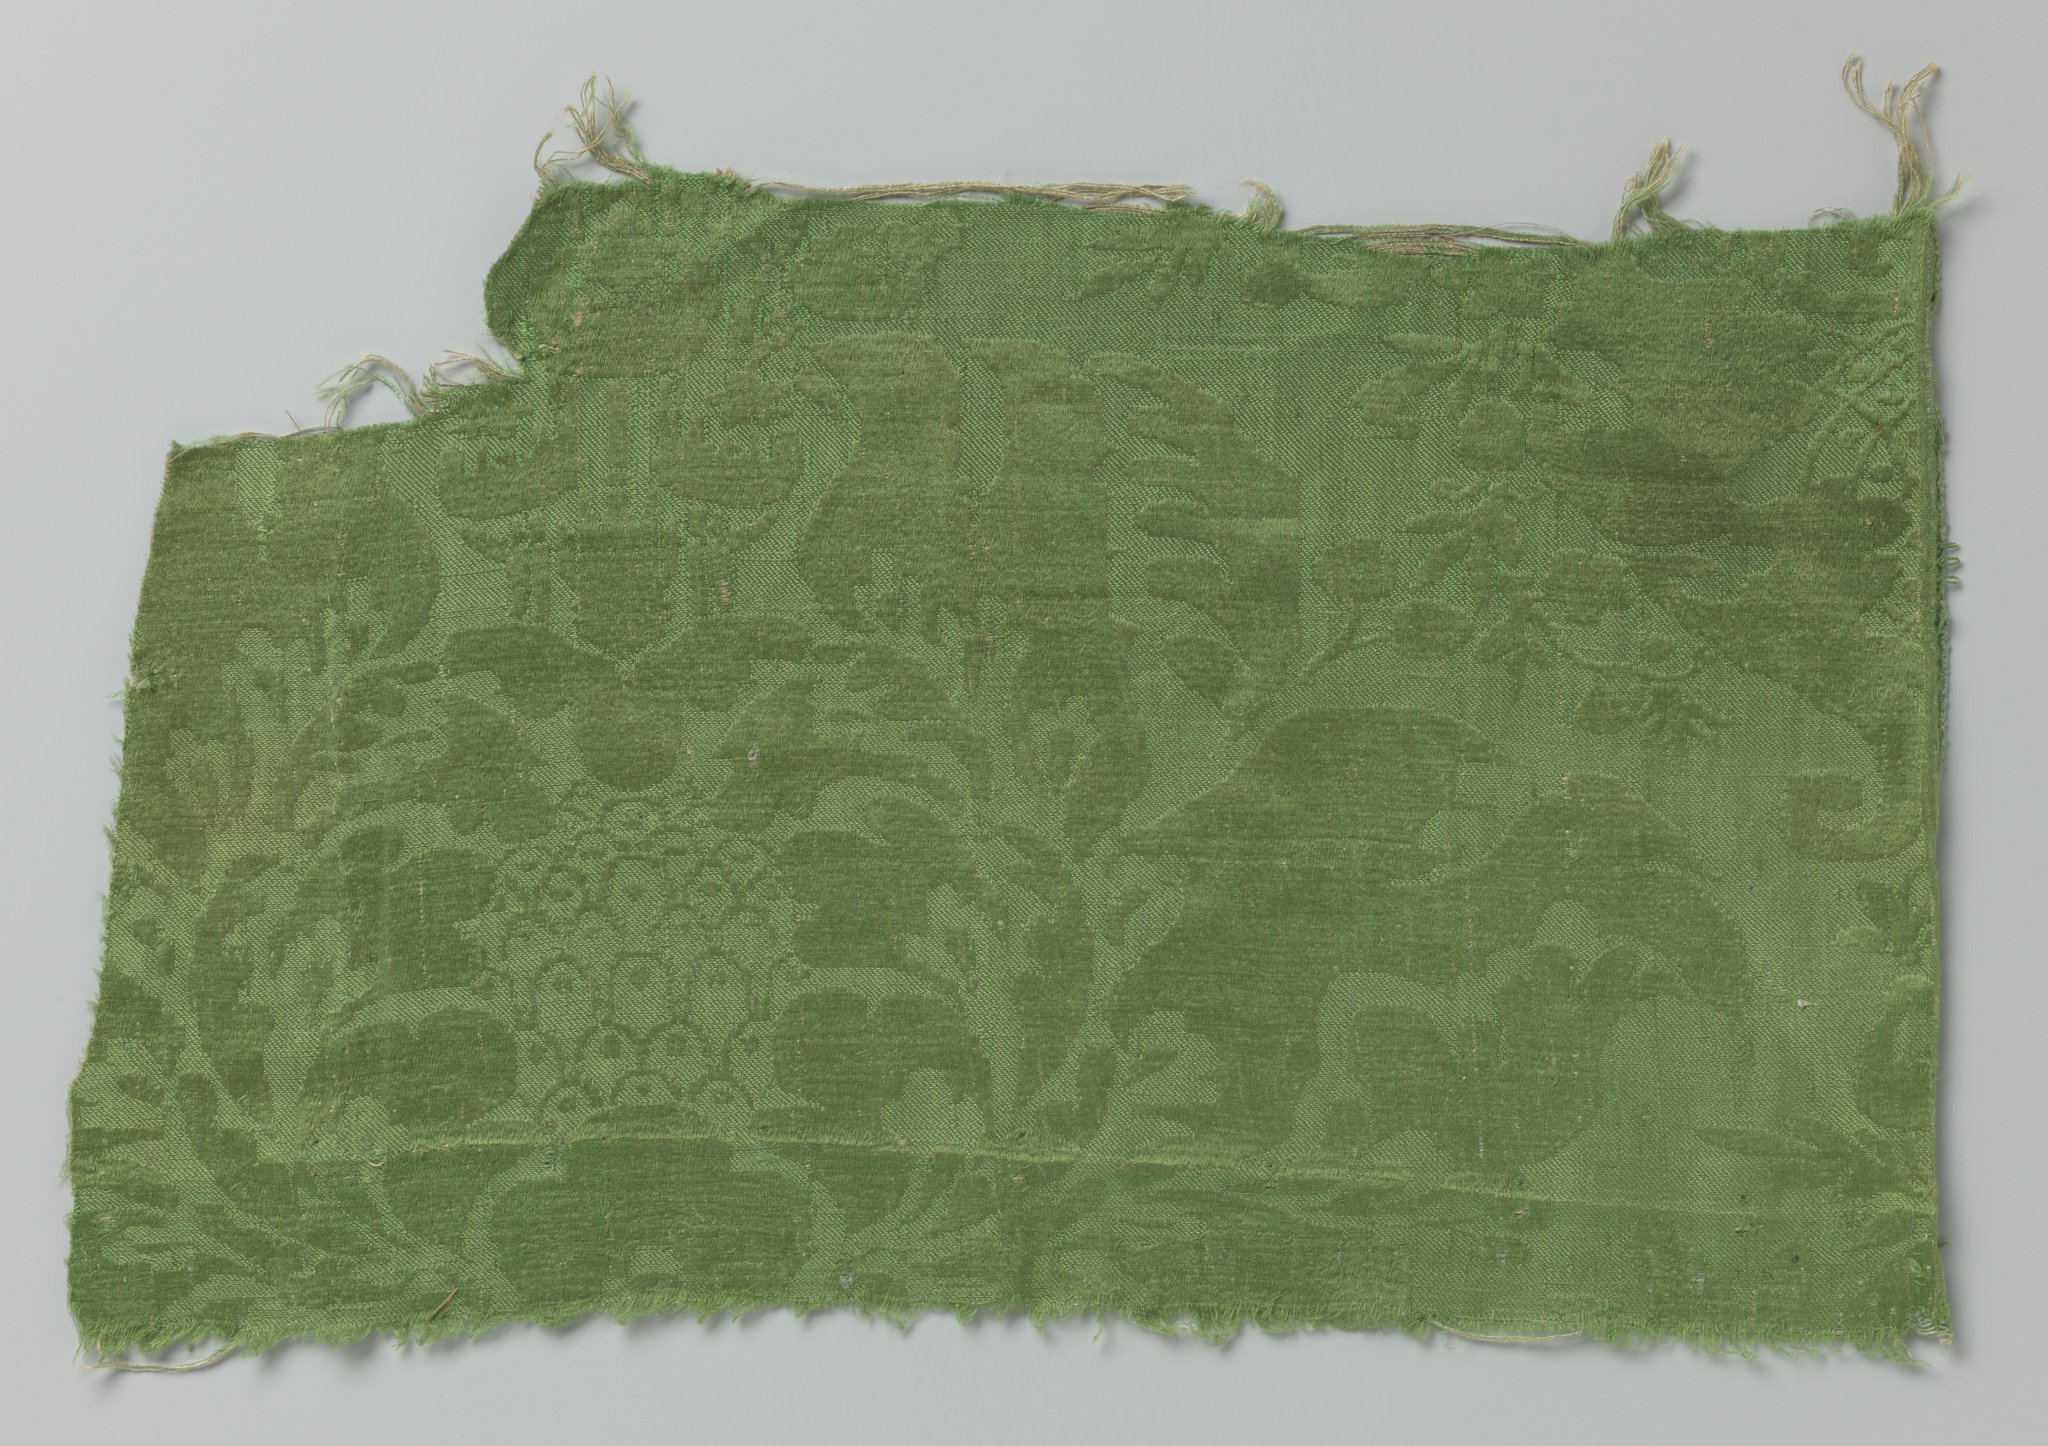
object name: upholstered wall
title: Wandbespanning van groen halfzijden damast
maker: Anonymous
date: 1700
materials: linen, silk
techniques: damask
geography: france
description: Wandbespanning van groen halfzijden damast. Zowel de inslag als de ketting van groene zijde zijn door naturel linnen versterkt. Weefselbinding van kettingsatijn op een fond van links stijgende keper. Het patroon is symmetrisch en beslaat de volle breedte: twee boven elkaar geplaatste motieven wisselen elkaar af tussen twee brede golvende, telkens oversneden stammen met netwerk patroon, dat door acanthusvoluten is omwonden. Motief 1: steunend op kleine neerhangende takken met vruchten bestaat uit een bloembodem, waarop in een boog gestelde grote vliezige, grillig ingesneden bloembladeren met links en rechts uitkomende bladsteel met bloem. Motief 2: vertoont een schaalvormig draagstuk met gigantische pioenachtige bloem met een netwerk hart, terwijl de schaal steunt op een middenstengel met uitstralende en neerhangende wier-achtige bladeren met rijkvertakte nervuren. In totaal 14 banen en 103 fragmenten.